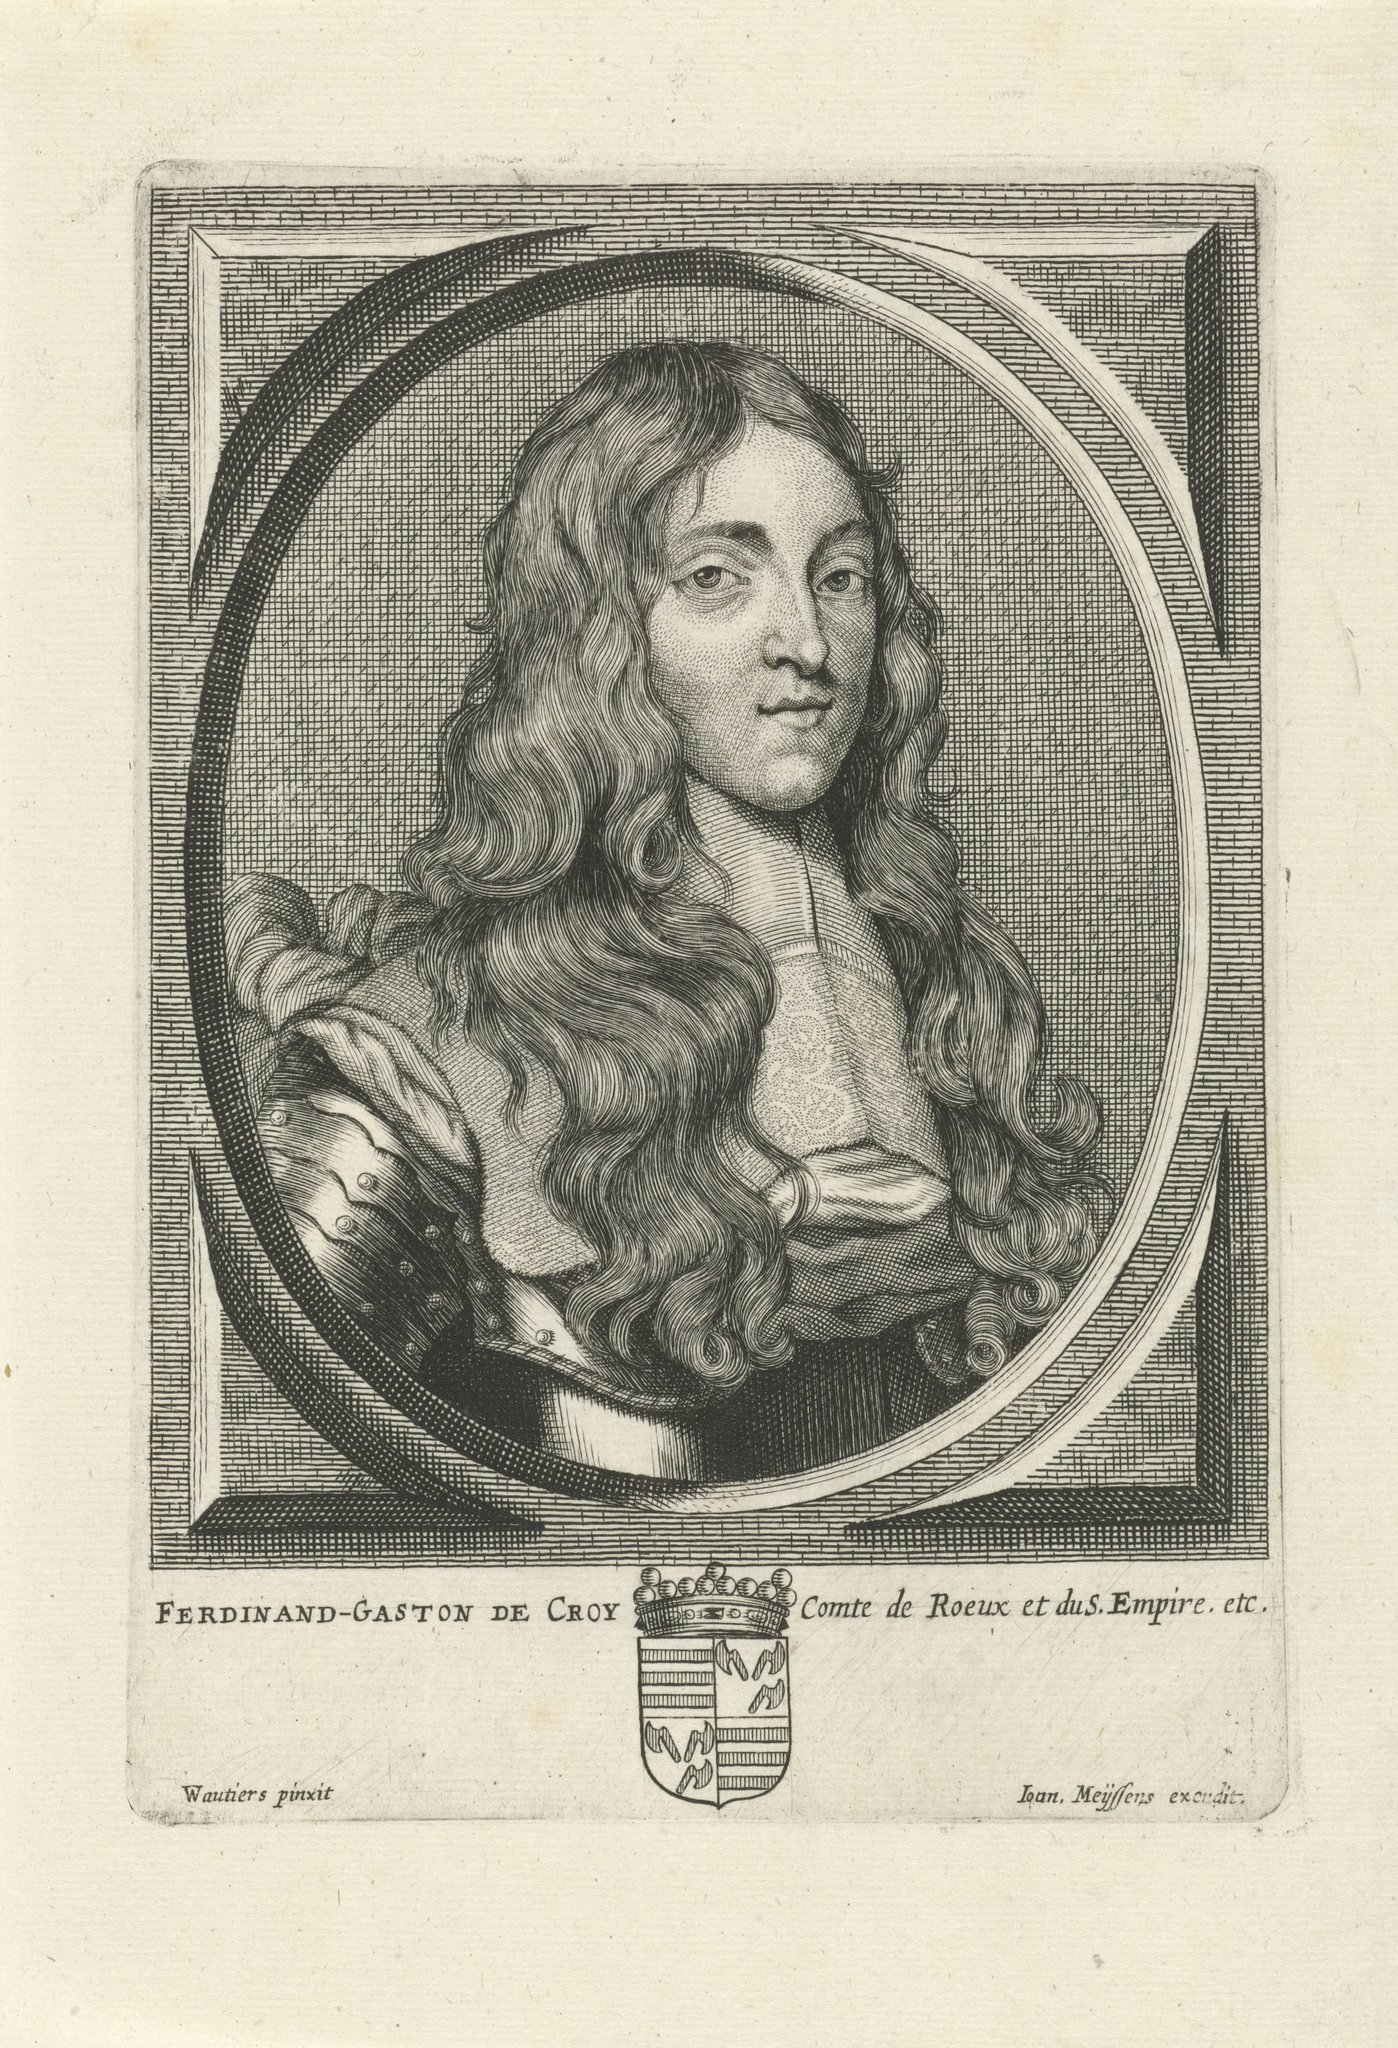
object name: print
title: Portret van Ferdinand Gaston Lamoral de Croÿ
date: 1650-1670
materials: paper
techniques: engraving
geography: antwerp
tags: ferdinand gaston lamoral de croÿ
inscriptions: collector's mark: Lugt 2228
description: Portret van Ferdinand Gaston Lamoral de Croÿ, graaf van Roeulx. Midden onder in de marge zijn wapenschild.